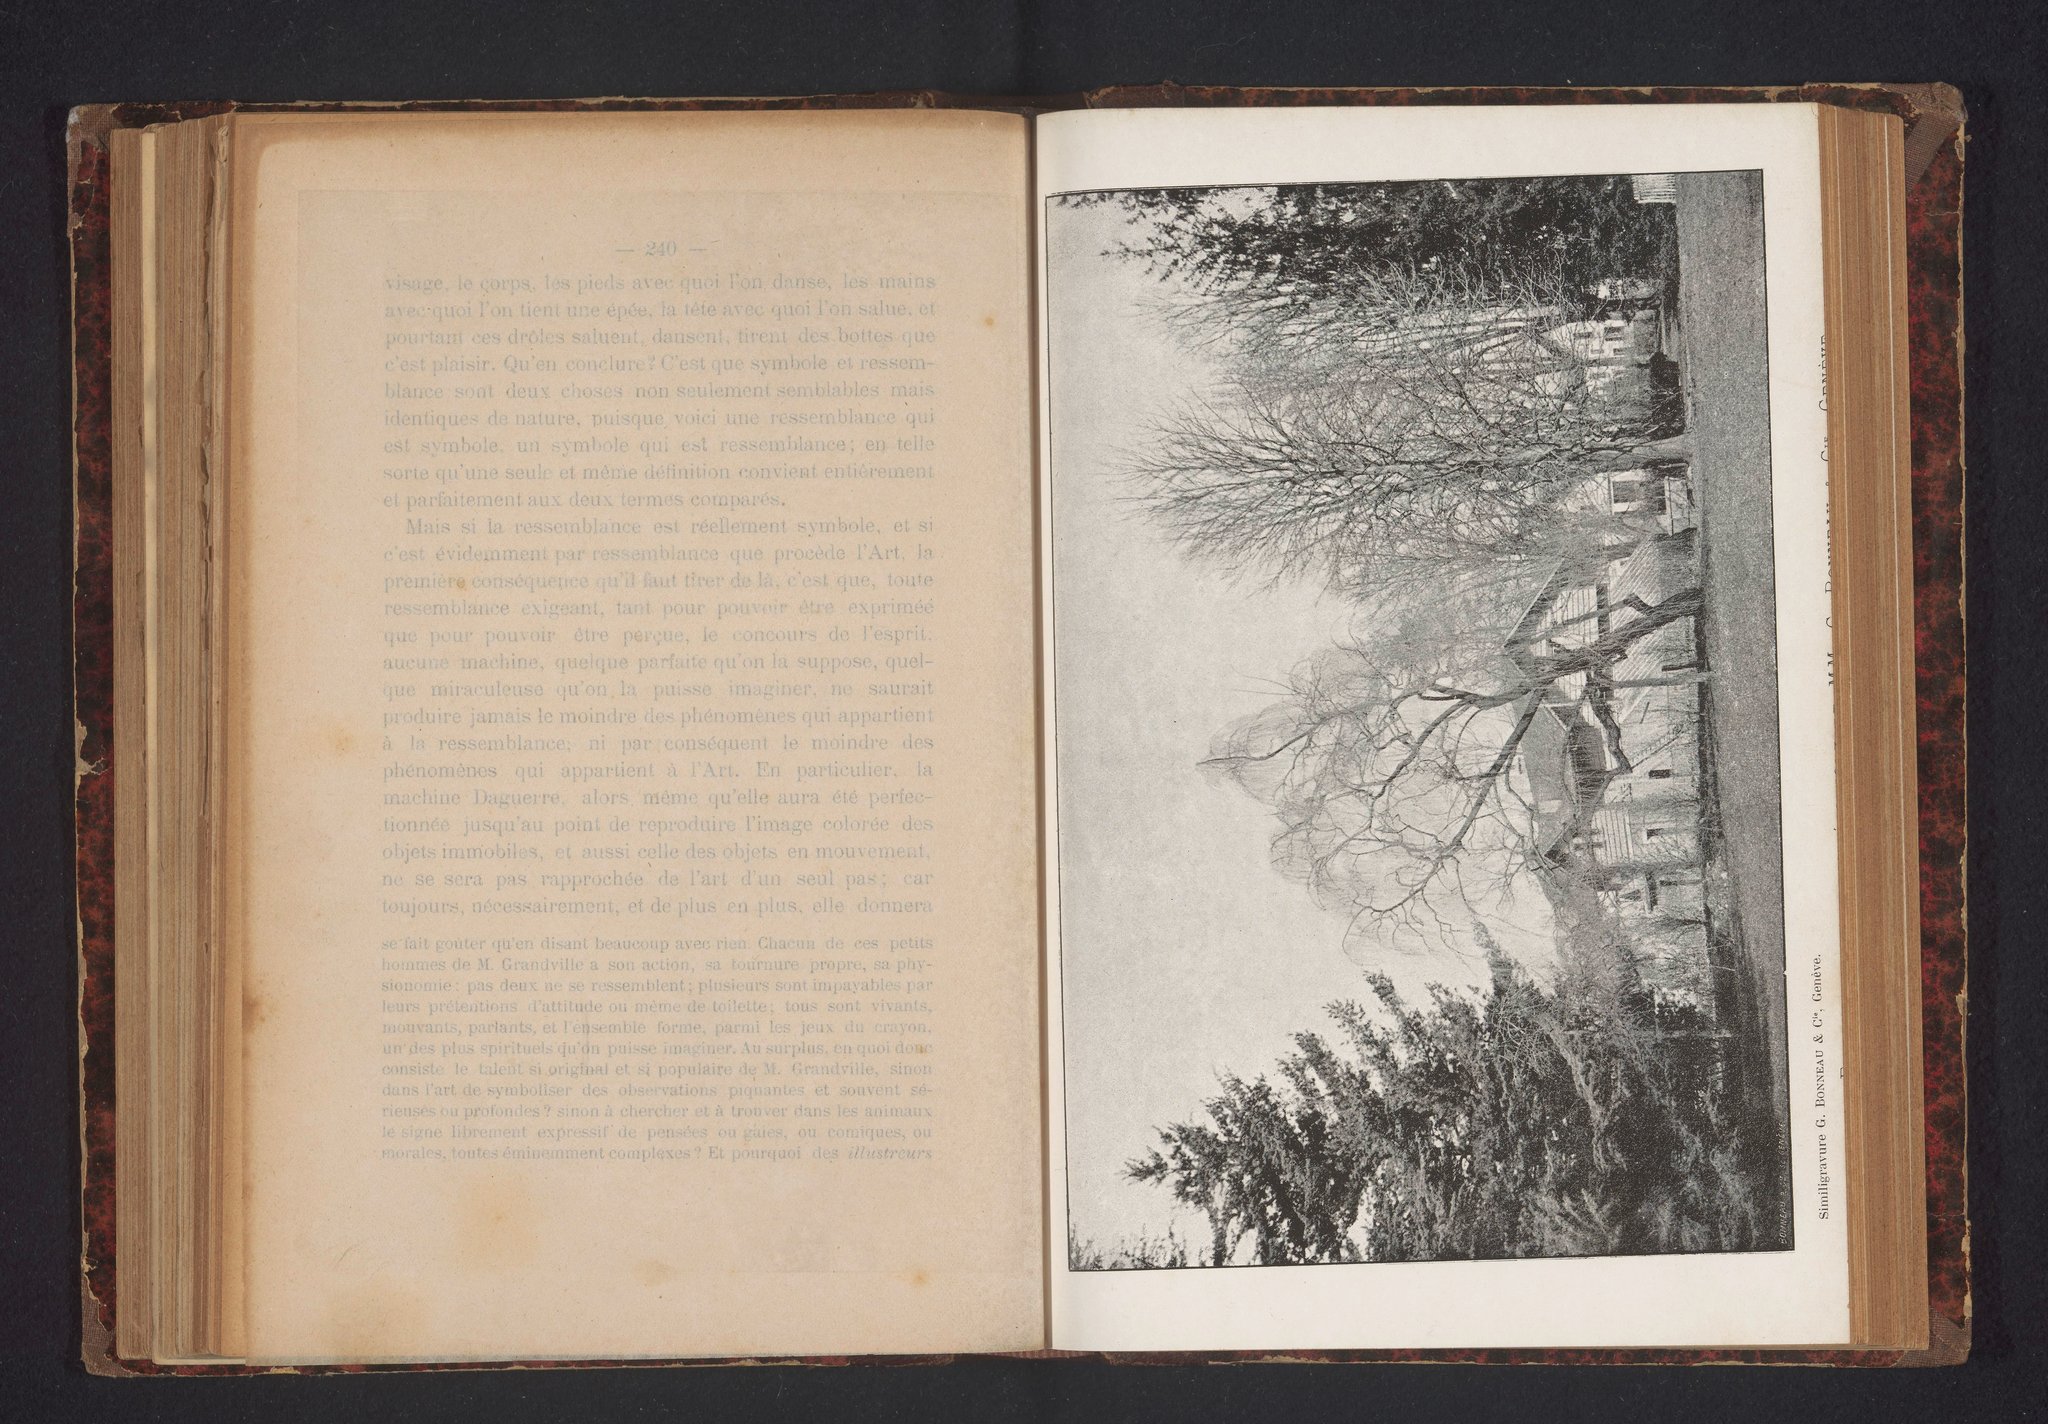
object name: photomechanical print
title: Gezicht op een woning en bomen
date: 1890-1895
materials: paper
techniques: autotype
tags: trees, housing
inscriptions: inscription: ‘[...]’